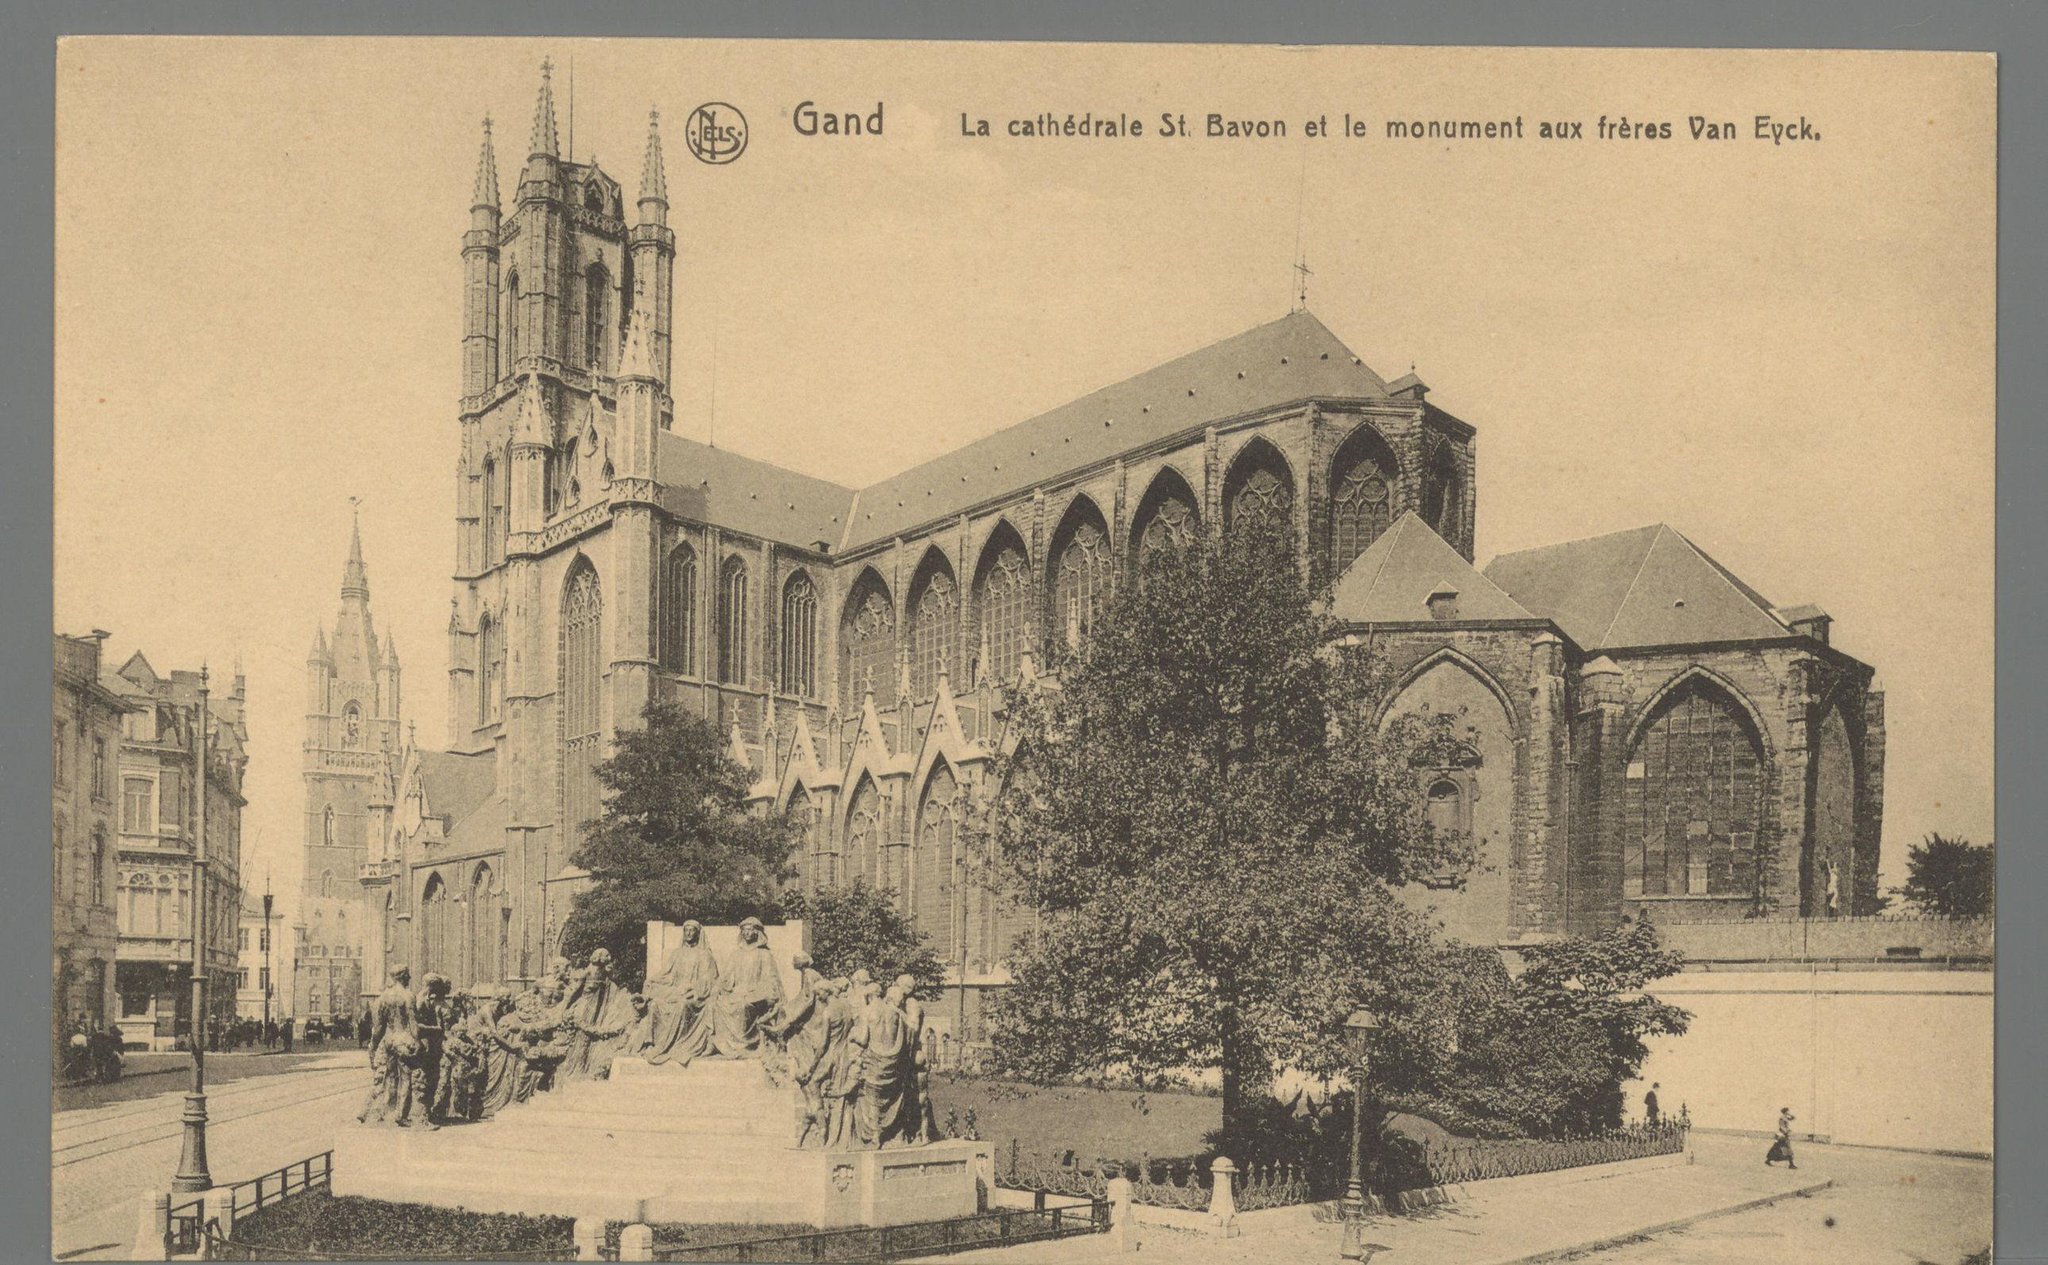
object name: photomechanical print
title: Serie 3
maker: Anonymous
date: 1907-1913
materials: cardboard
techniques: photograph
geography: ghent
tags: church (exterior), city-view, and landscape with man-made constructions (+ city(-scape) with figures, staffage)